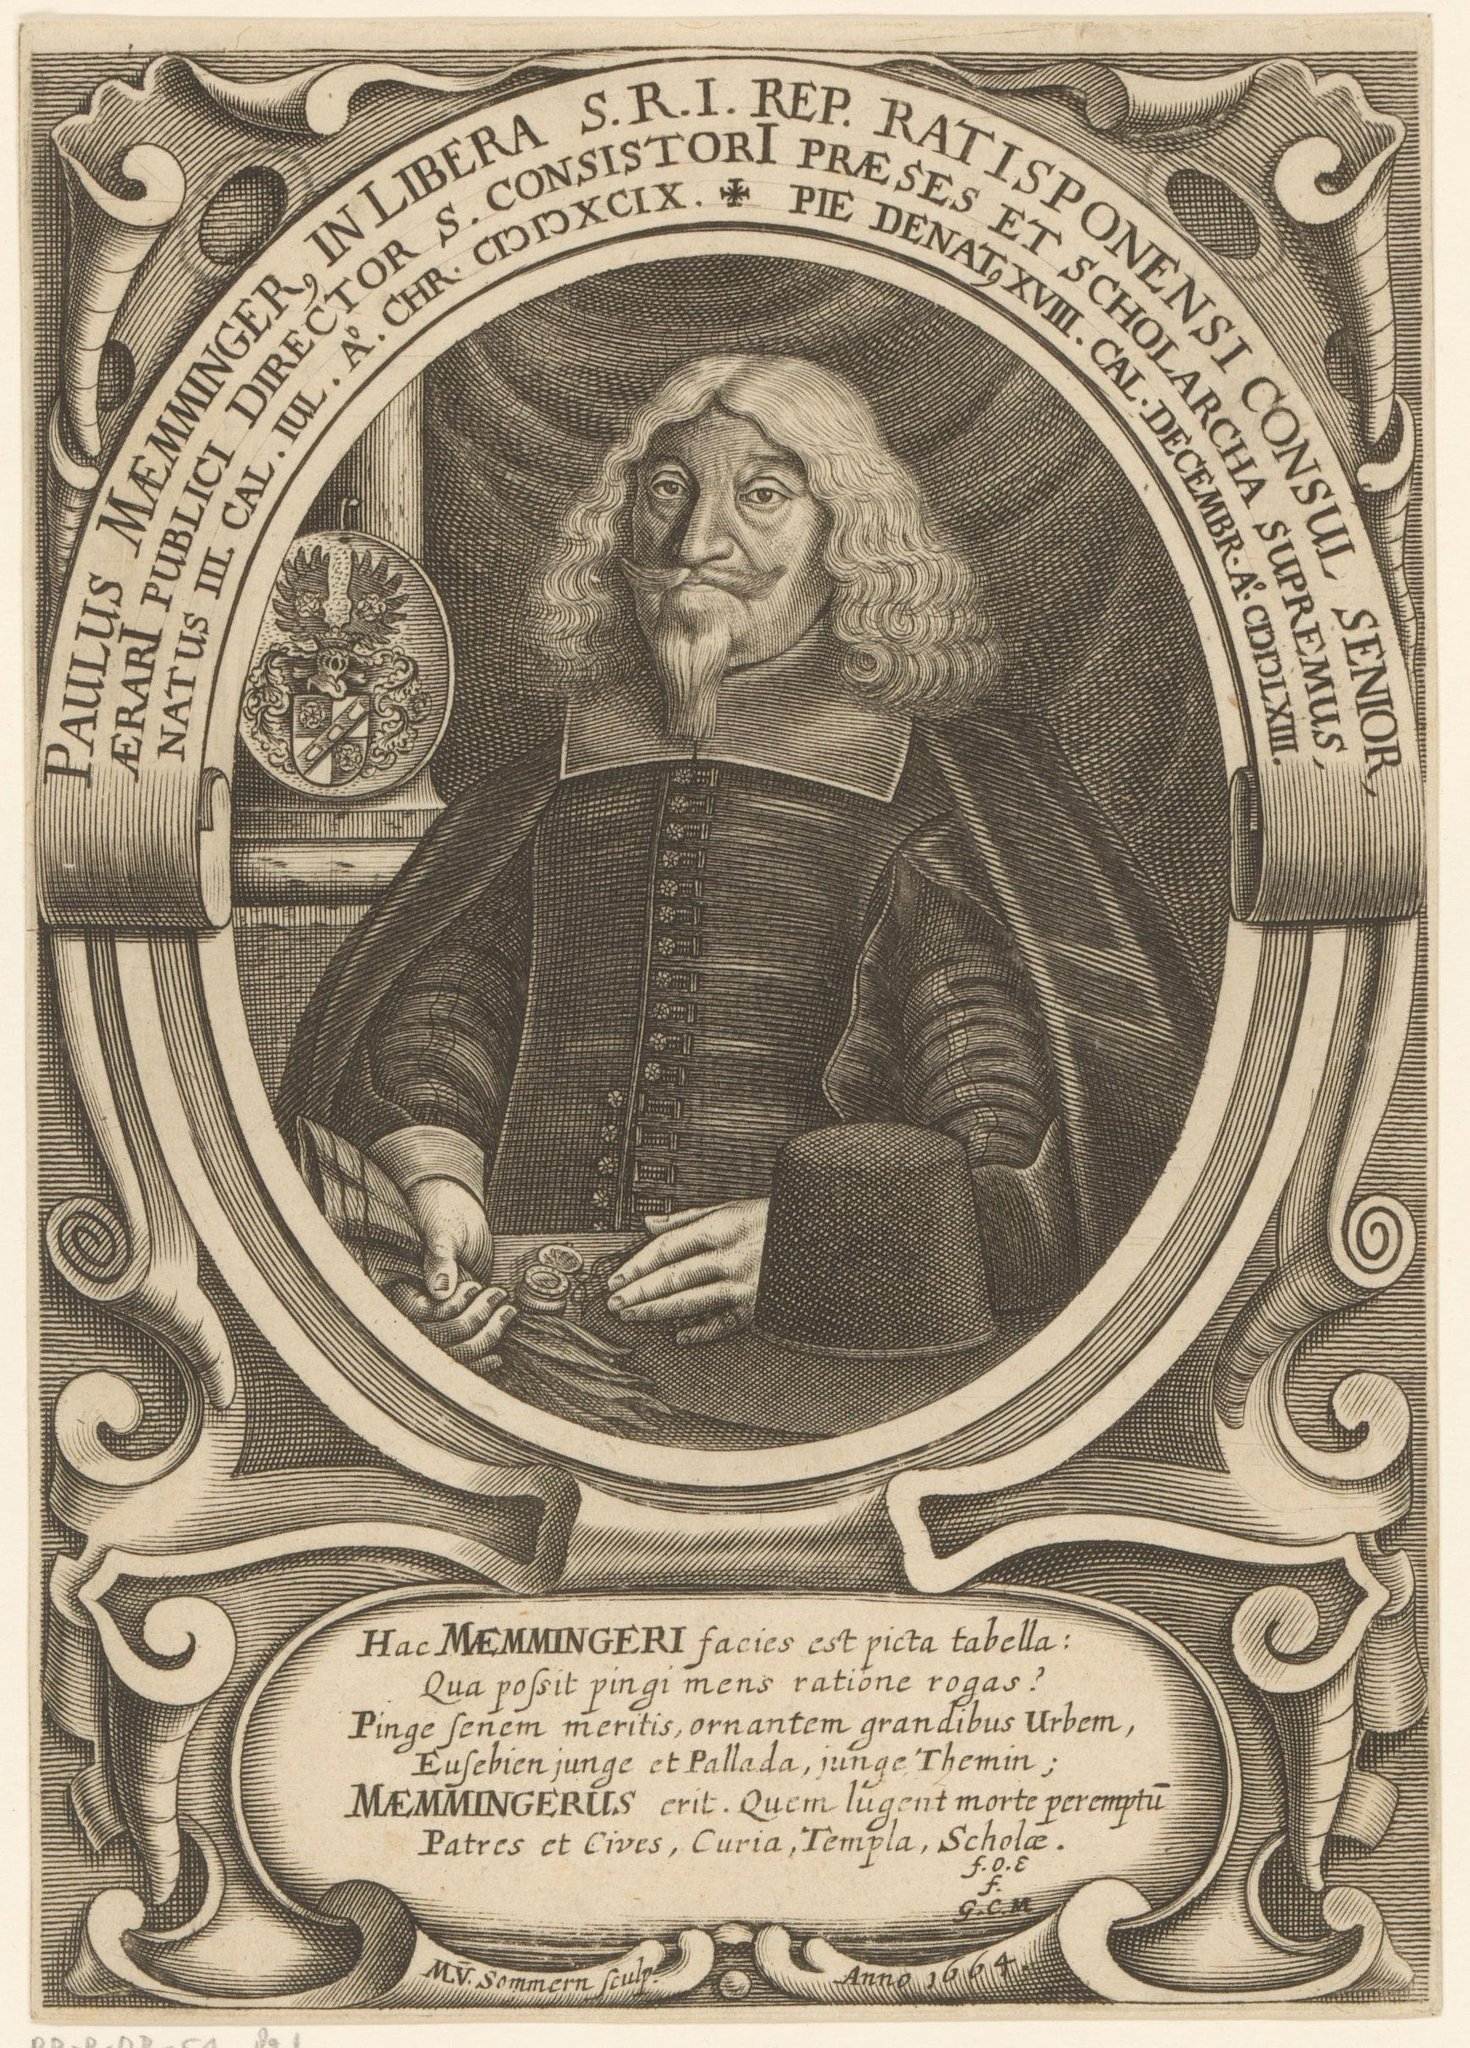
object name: print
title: Portret van Paul Maemminger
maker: matthias van sommer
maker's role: draughtsman, print maker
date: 1664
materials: paper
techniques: engraving, etching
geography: germany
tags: gloves, mittens, etc., historical persons, baton of general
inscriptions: collector's mark: Lugt 2228